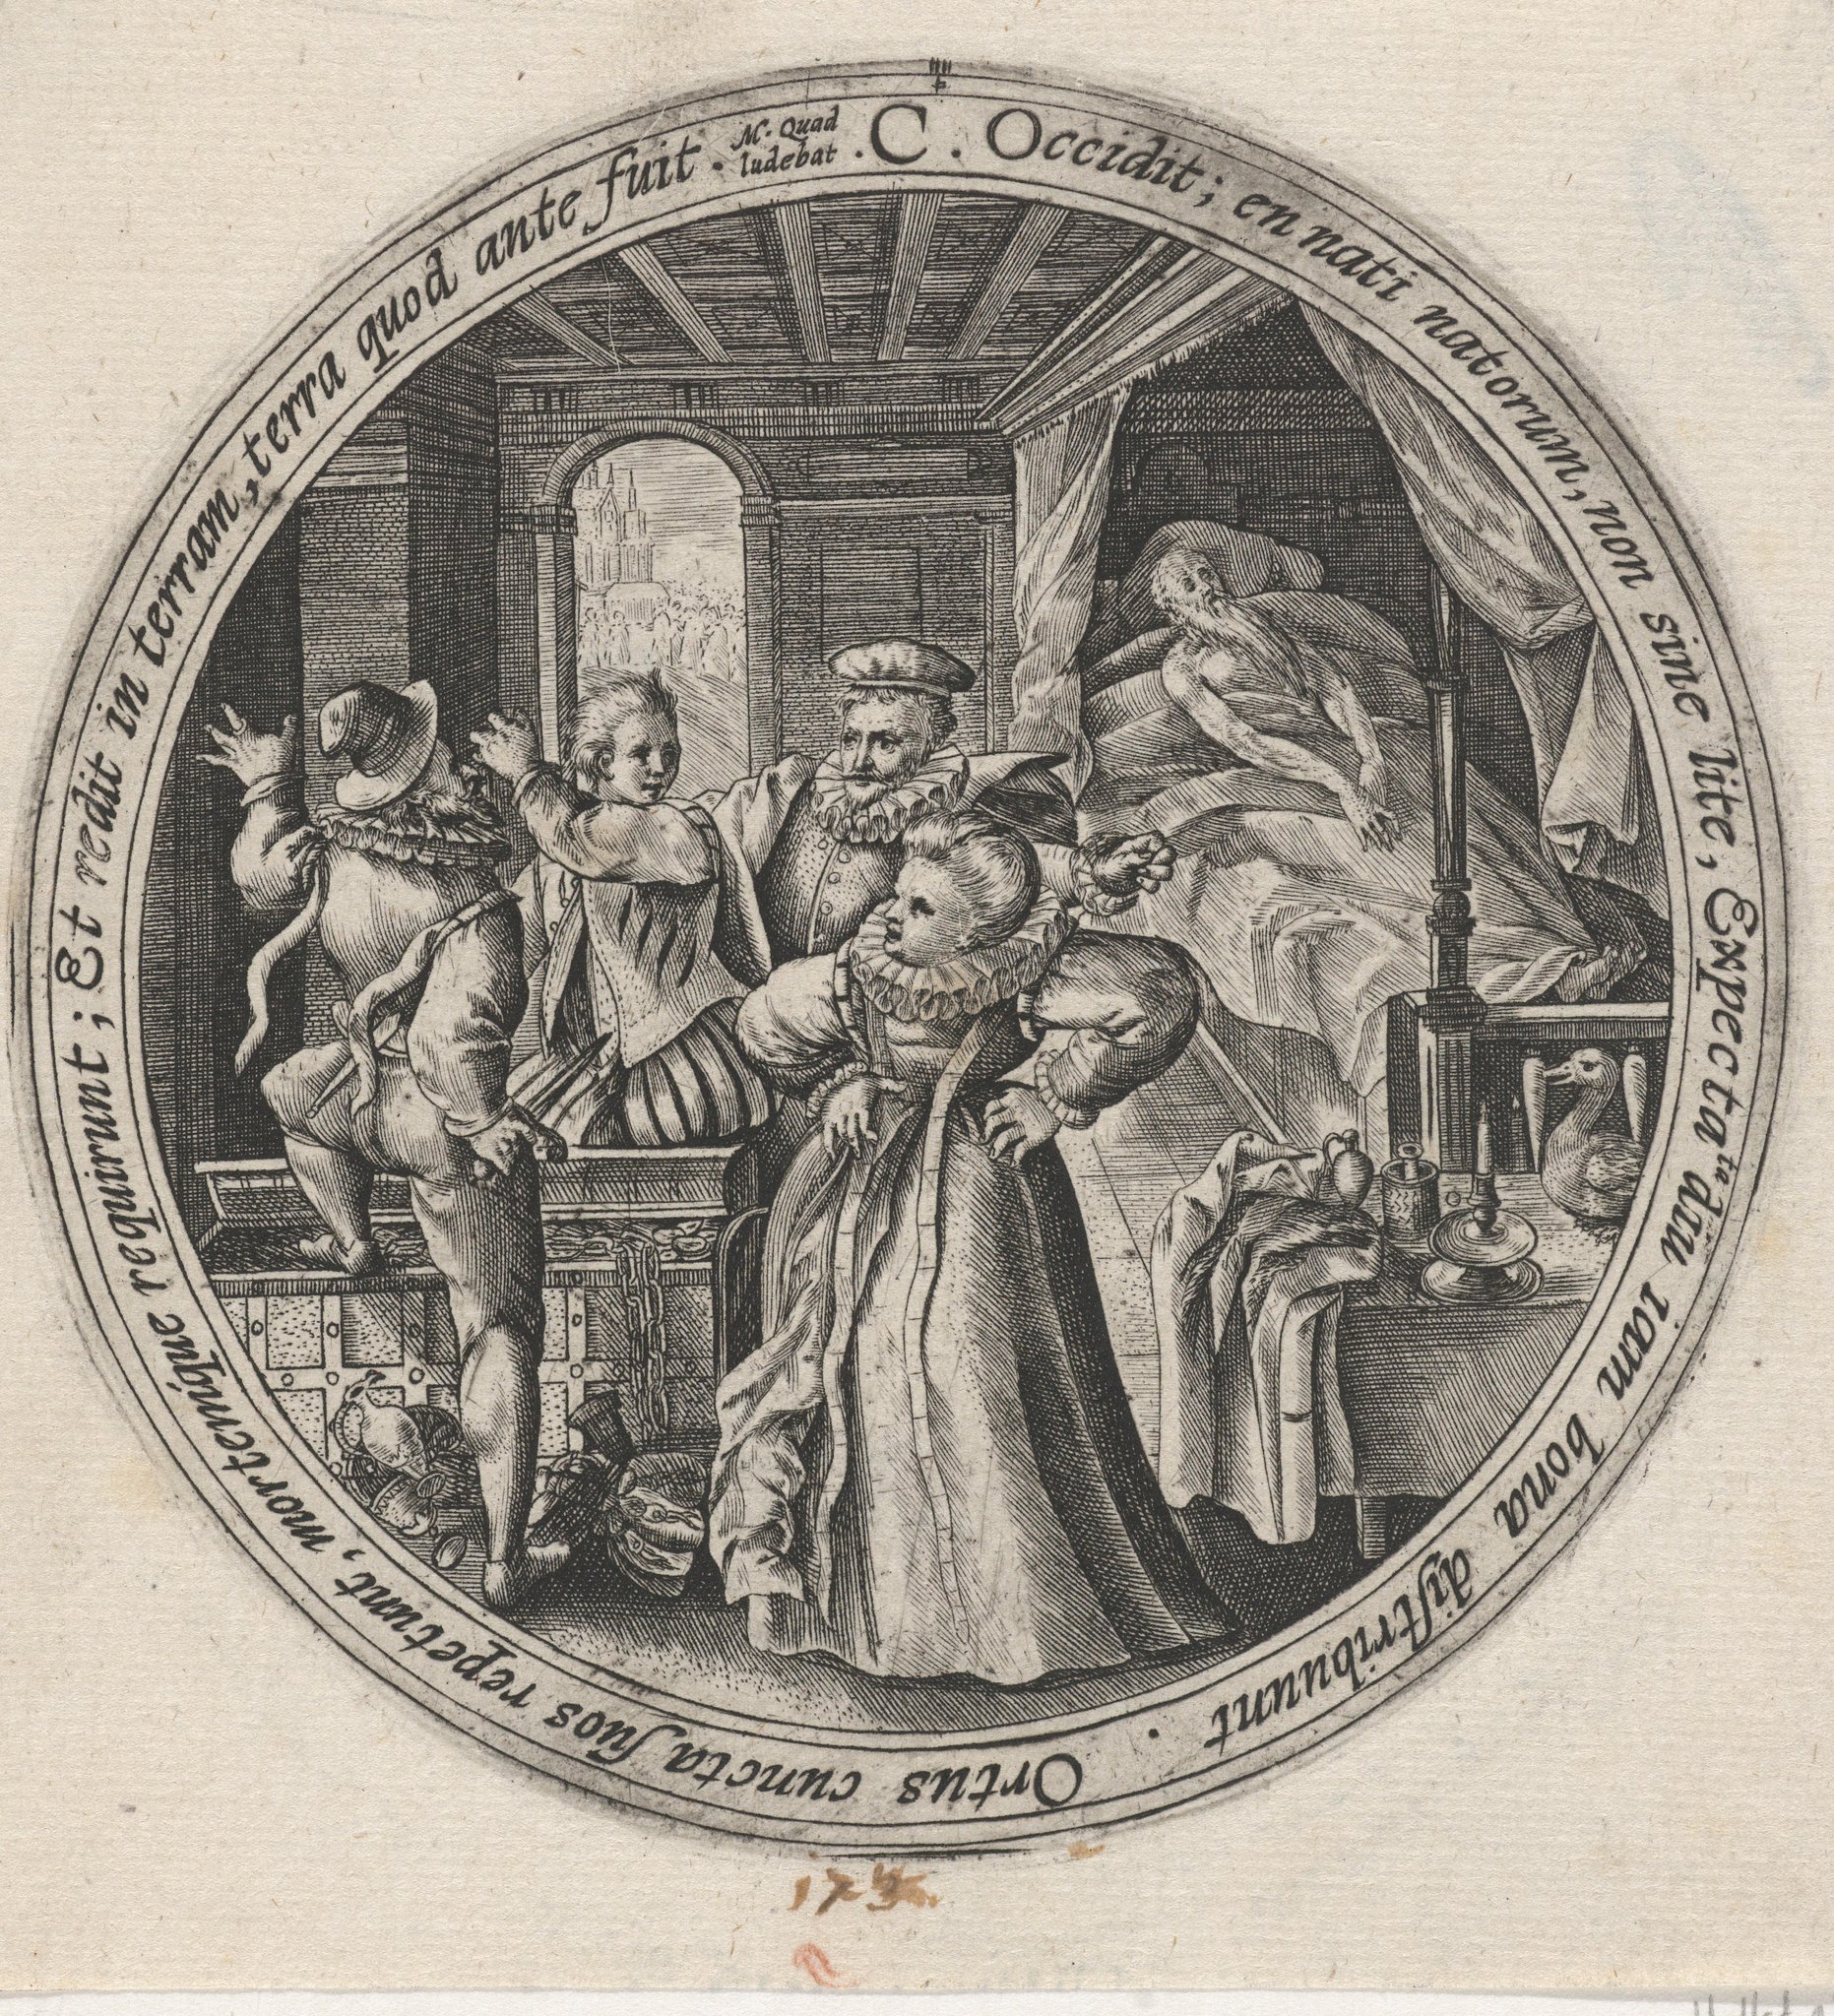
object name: print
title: Tien leeftijden van de mens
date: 1574-1637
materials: paper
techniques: engraving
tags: quarrelling heirs, 90-100 years, deathbed, old man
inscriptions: collector's mark: Lugt 2228, number: ‘173’, collector's mark: Lugt 2161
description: Vertrek met een oude man op zijn sterfbed en drie mannen en een vrouw bij een kist die ruzie maken over de erfenis. Op een tafel een eend. Op de achtergrond de begrafenisstoet. In de omlijsting een randschrift in het Latijn. Tiende prent uit een serie van tien met de tien leeftijden van de mens.